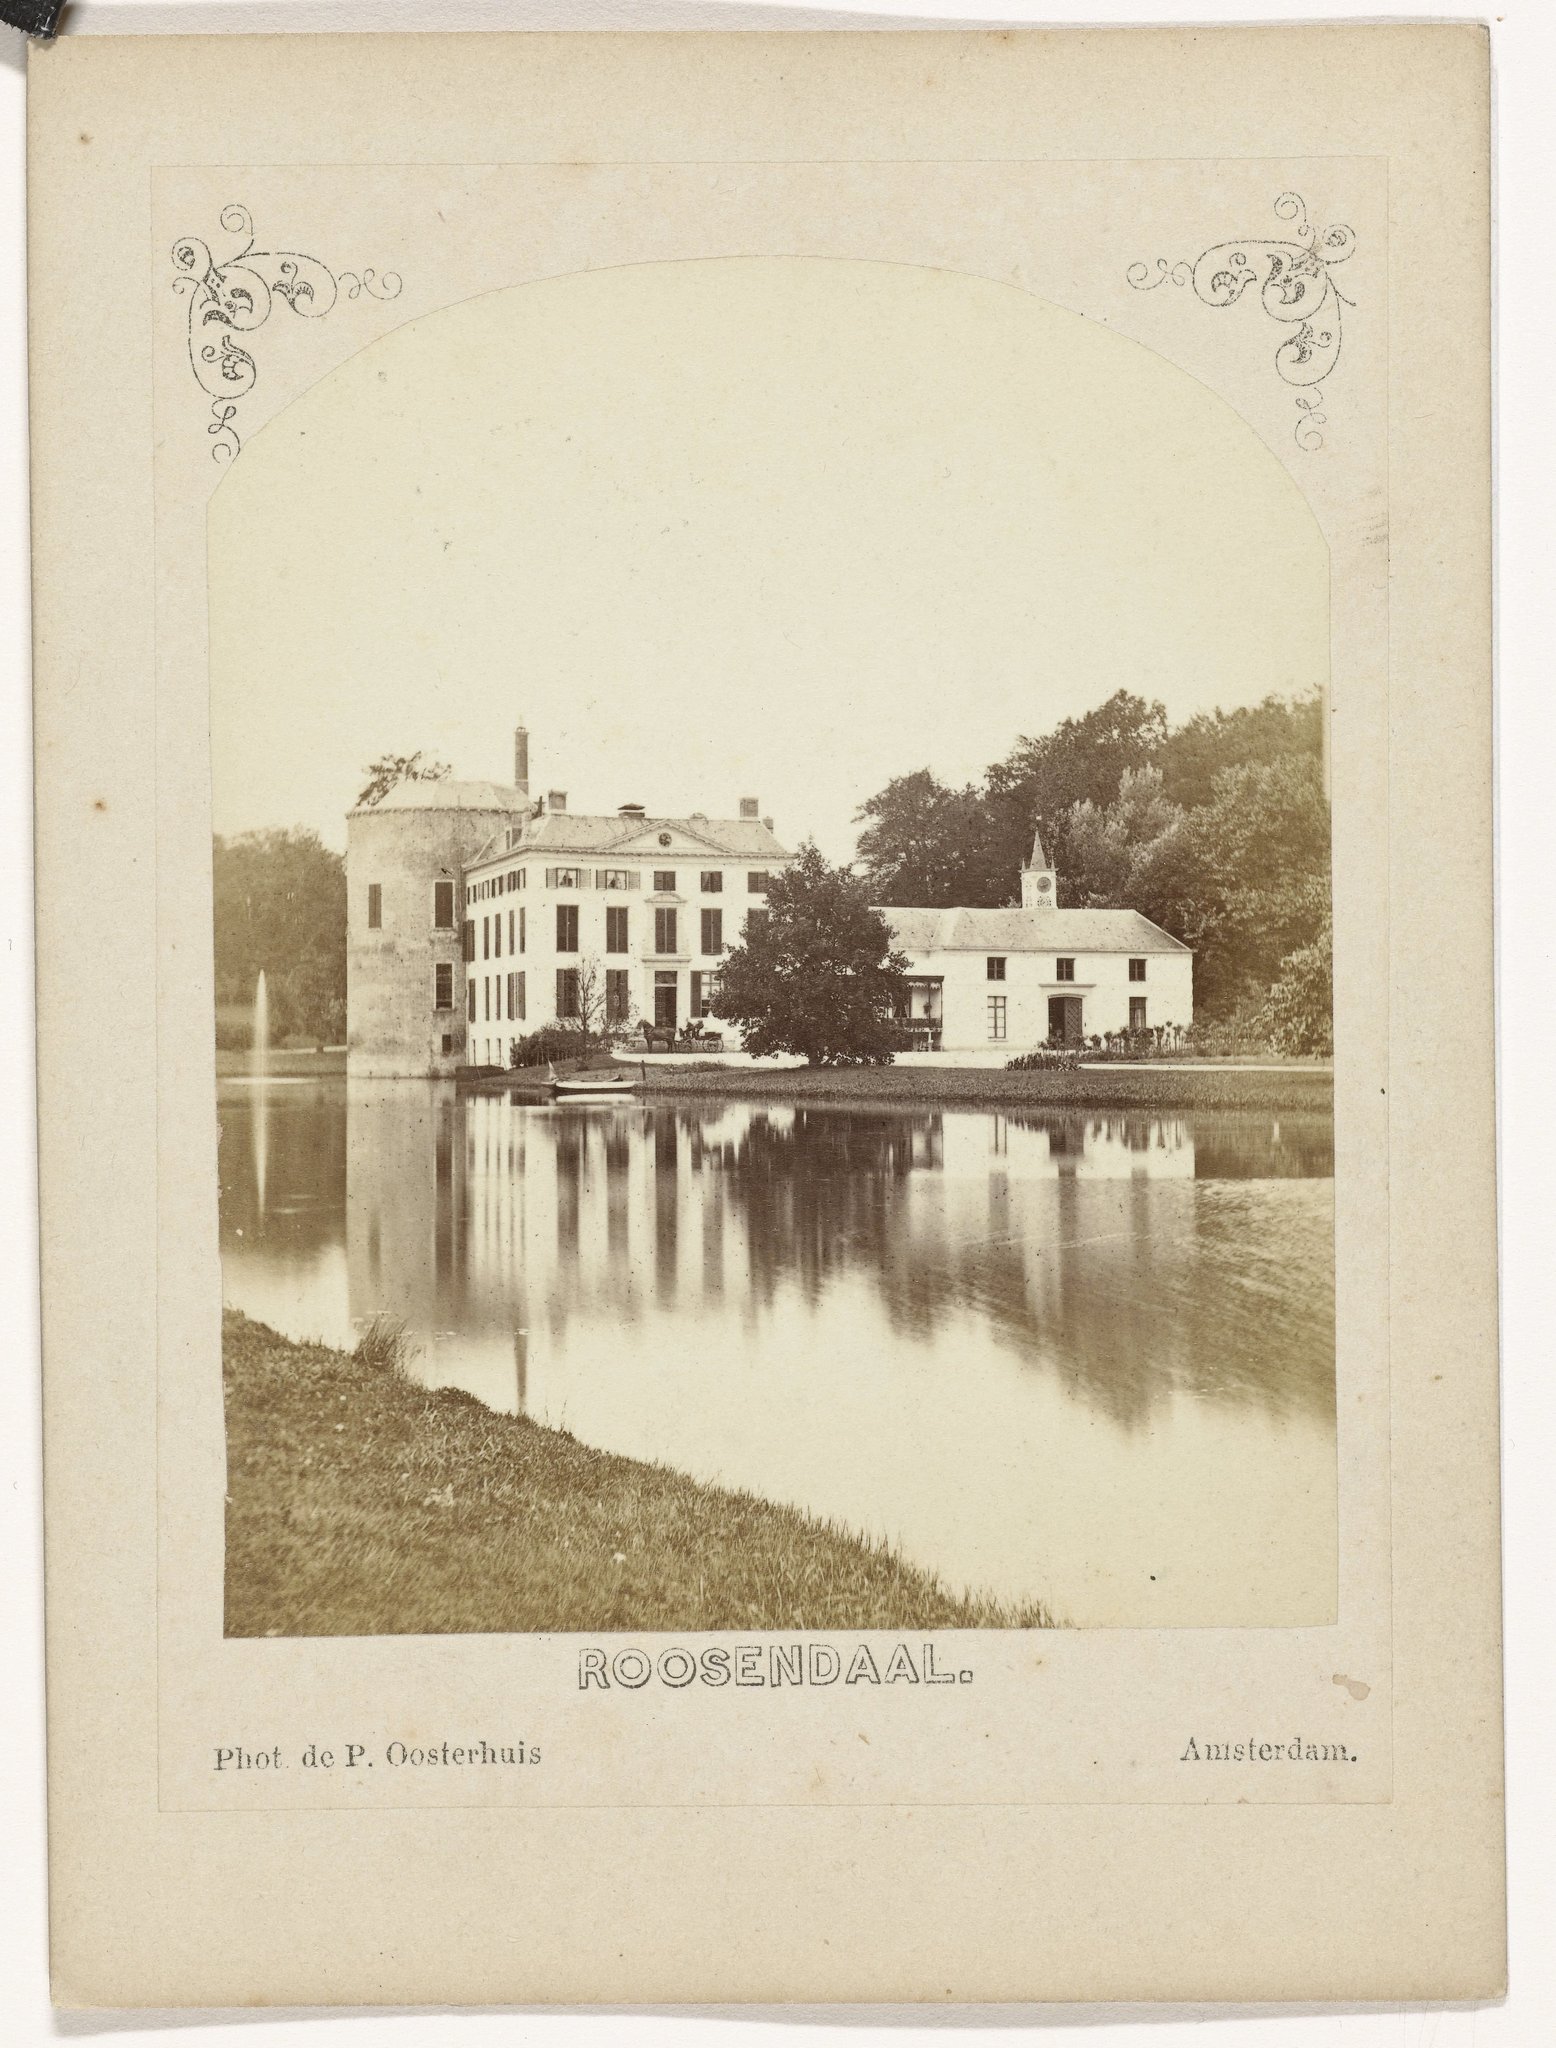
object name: photograph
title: Roosendaal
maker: pieter oosterhuis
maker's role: draughtsman, print maker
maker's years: 1816-1885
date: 1867-1880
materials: cardboard, paper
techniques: albumen print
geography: amsterdam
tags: country-house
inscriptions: name: ‘Phot de P. Oosterhuis Amsterdam’